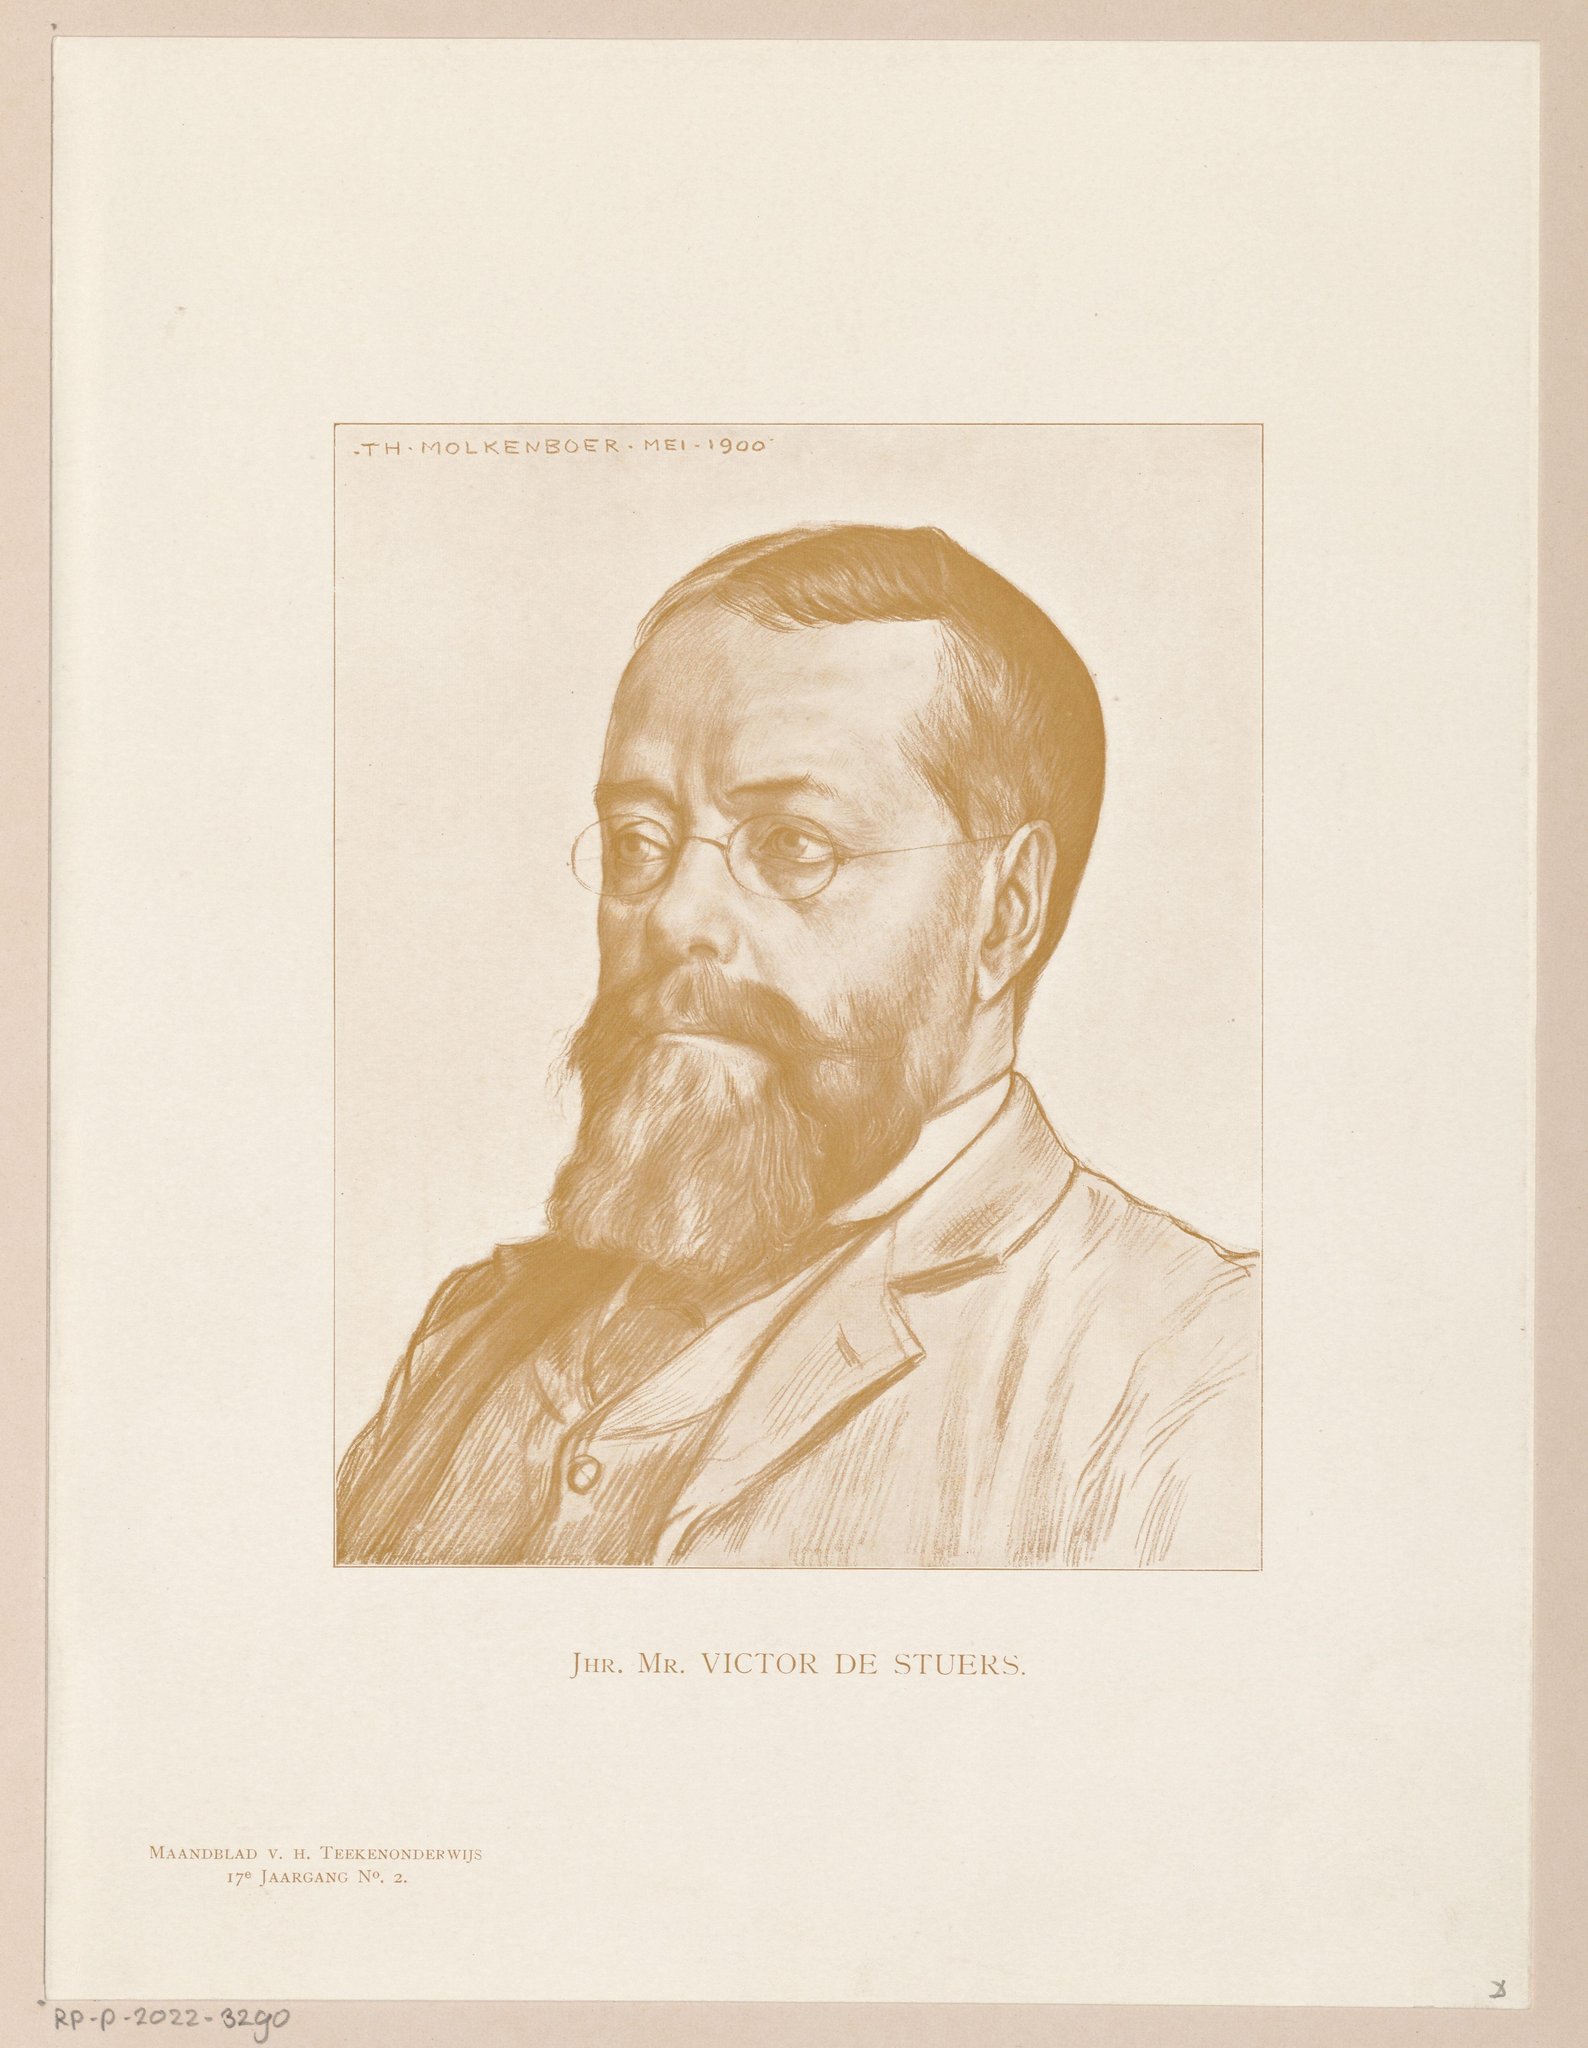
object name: photomechanical print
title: Portret van Victor de Stuers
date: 1900-1901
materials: paper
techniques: autotype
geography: netherlands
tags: the hague, politician, victor de stuers, historical persons, politician, e.g. party leader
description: Prent uit: Maandblad voor het Teekenonderwijs. Jrg.17, 2. (1900-1901).